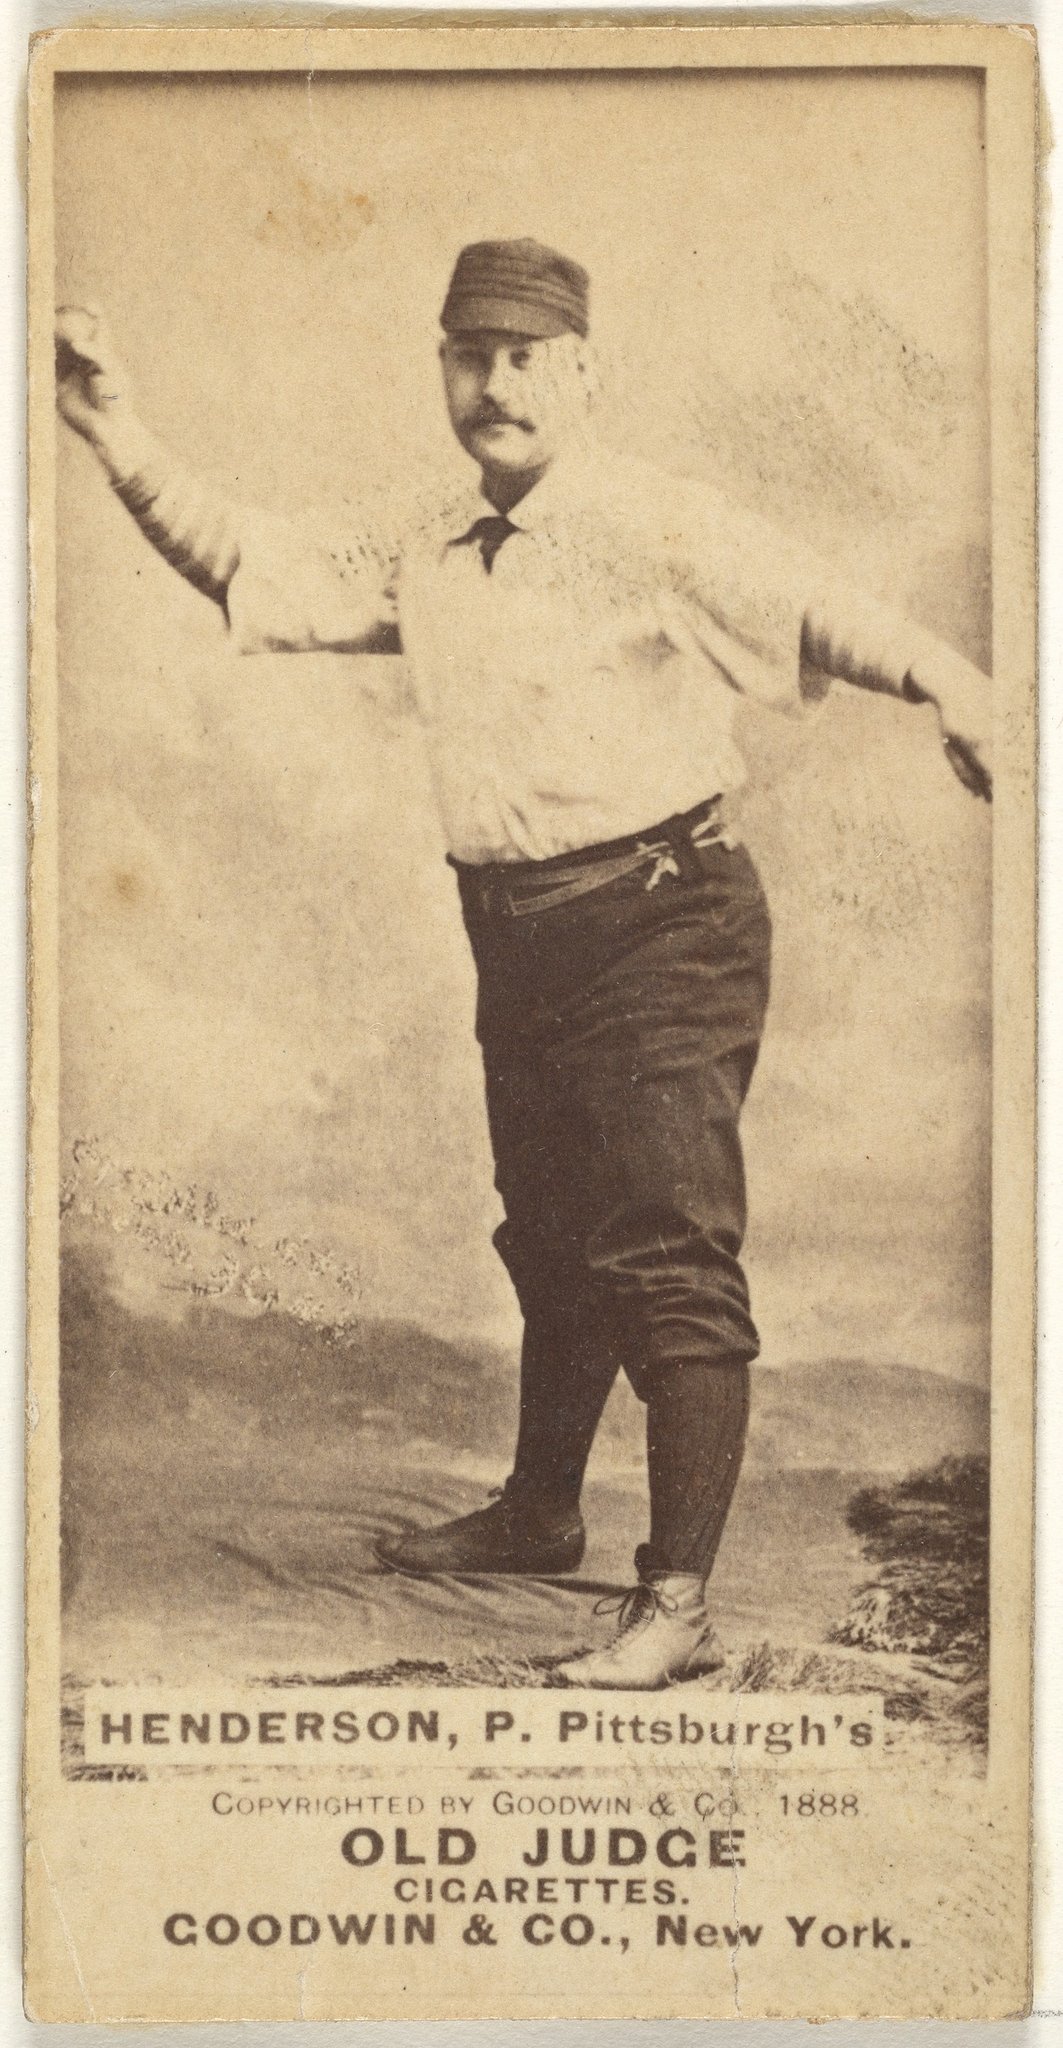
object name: baseball card, photograph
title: James "Hardie" Harding Henderson, Pitcher, Pittsburgh, from the Old Judge series (N172) for Old Judge Cigarettes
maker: goodwin & company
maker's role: publisher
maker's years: 1850-1950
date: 1888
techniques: albumen silver print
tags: men,portraits,baseball,athletes